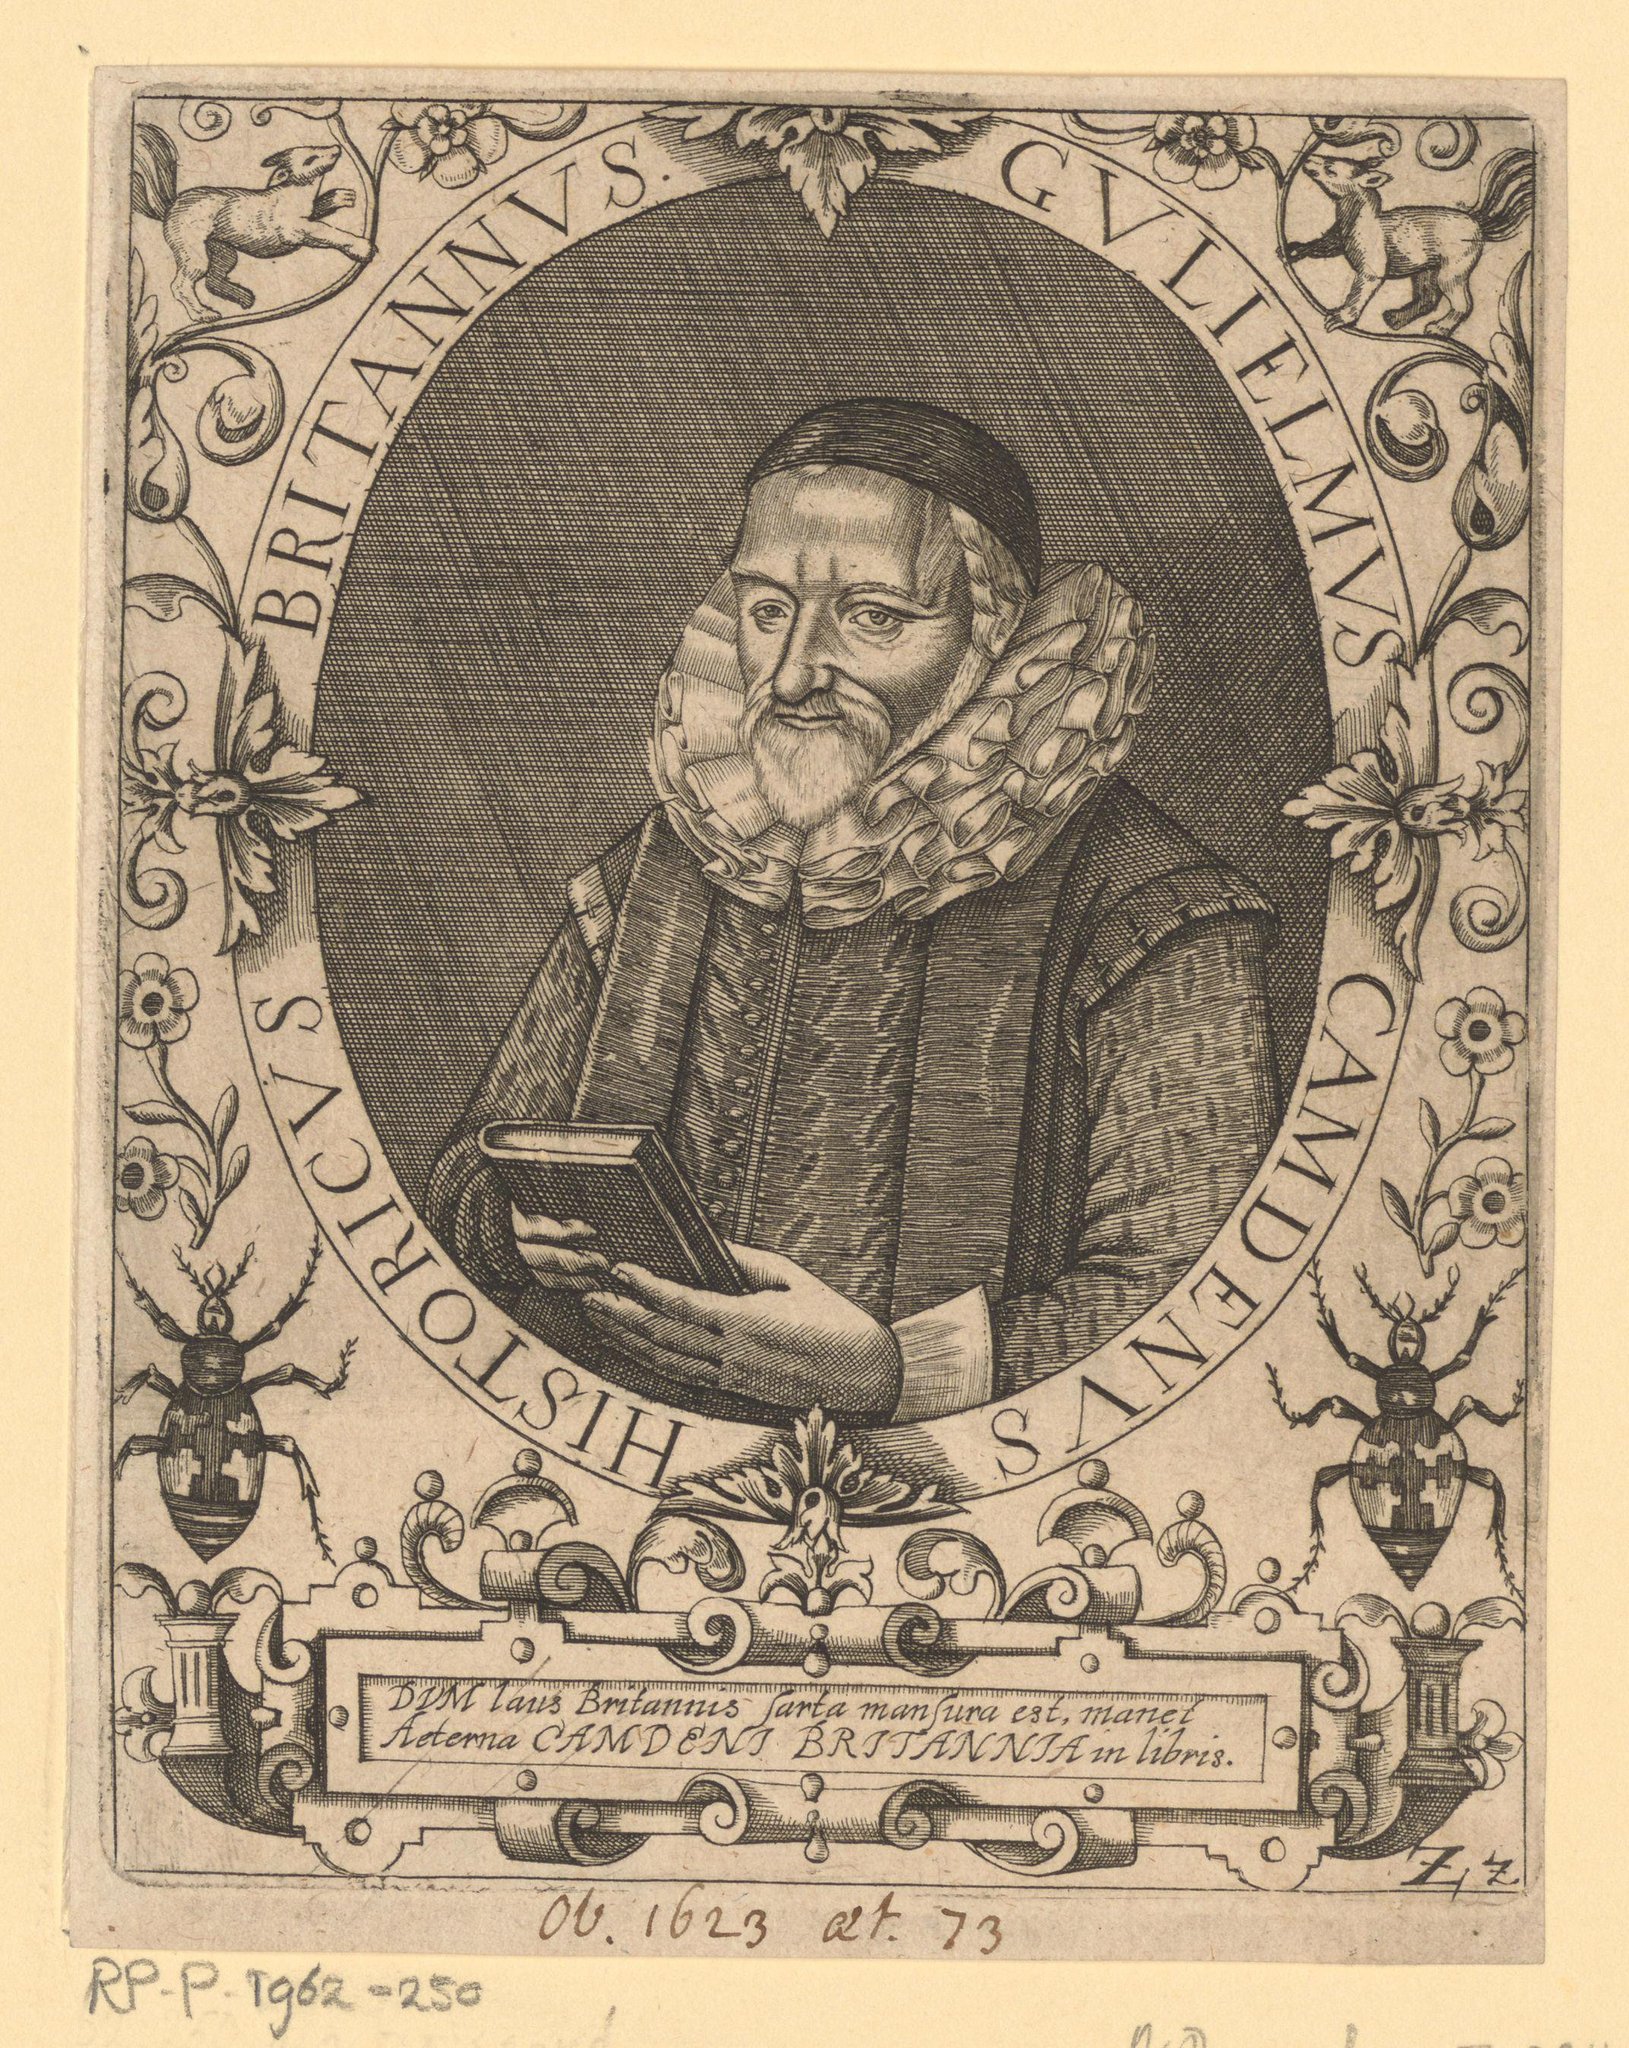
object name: print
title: Portret van William Camden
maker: jean jacques boissard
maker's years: 1528-1598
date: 1650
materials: paper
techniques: engraving, etching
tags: historical persons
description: Prent waarschijnlijk uit: Boissard, Jean Jacques. Bibliotheca chalcographica. 8 dln. Frankfurt am Main: Johannes Ammon, 1650. Ook gebruikt in latere edities. Eerdere staat van prent verschenen in: Boissard, Jean Jacques. Icones quinquaginta virorum illustrium doctrina & eruditione praestantium ad vivum effictae. 4 dln. Frankfurt am Main: s.n., 1597-1599. Mogelijk ook gebruikt in latere edities.